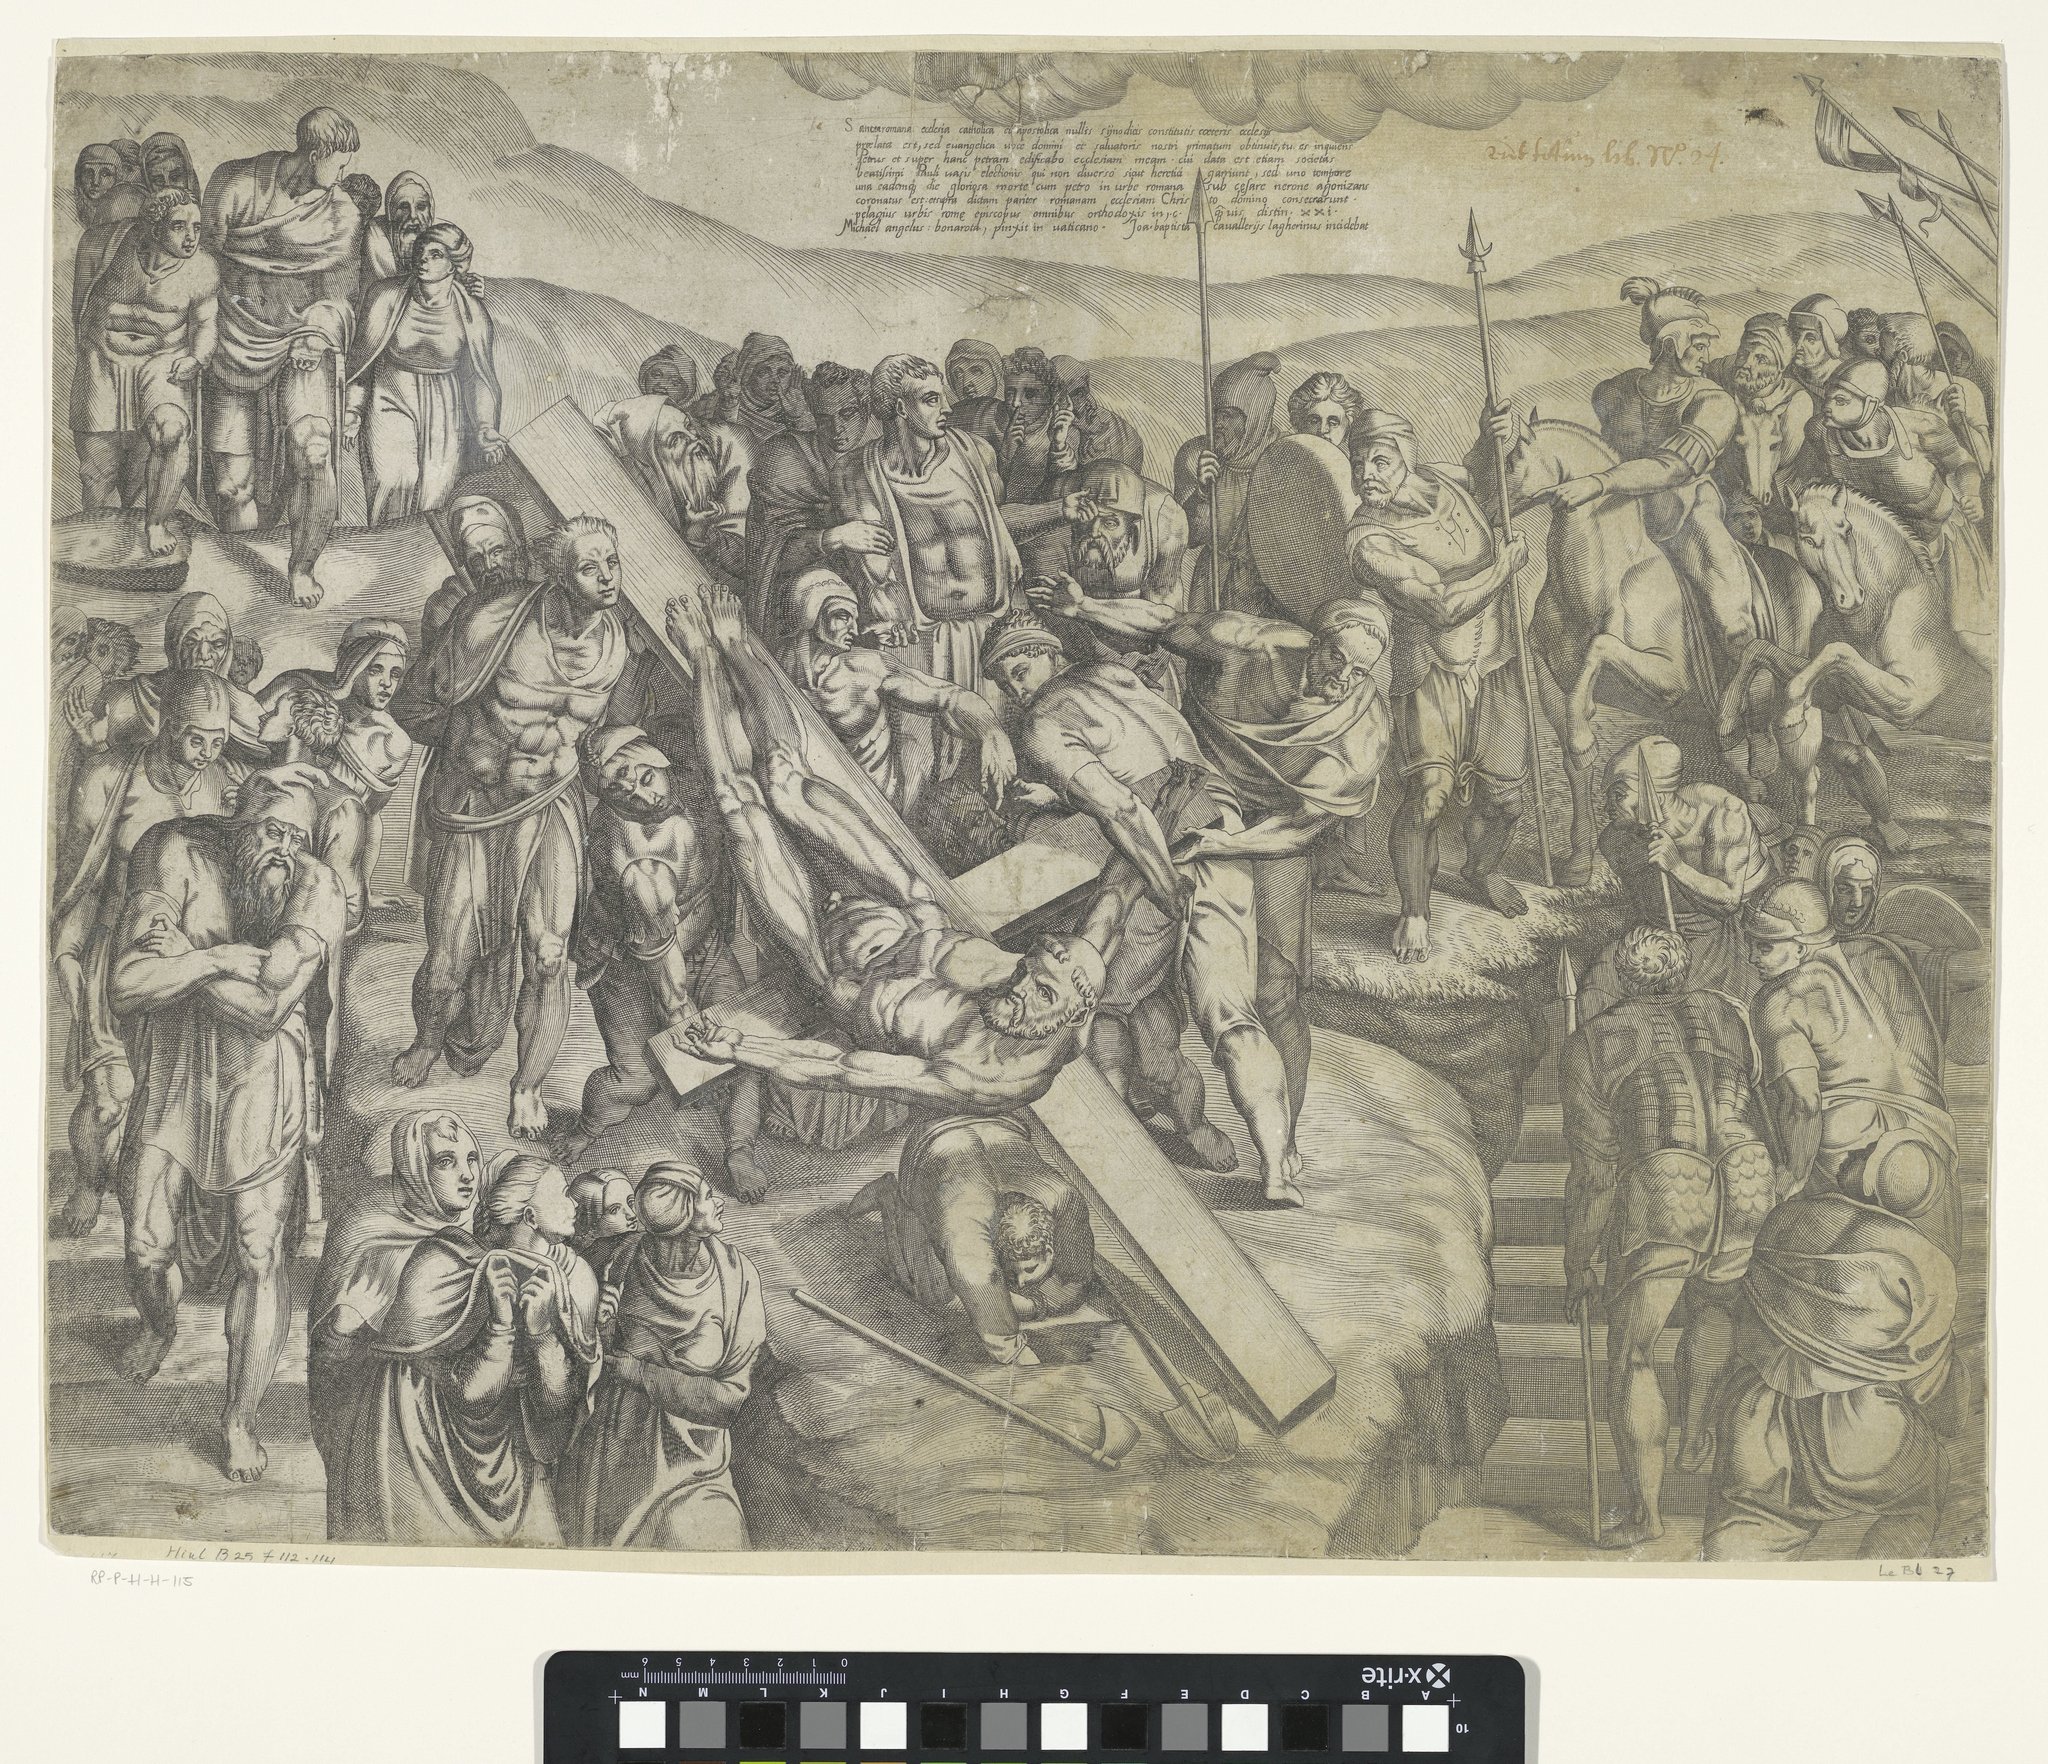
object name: print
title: Kruisiging van Petrus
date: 1535-1601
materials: paper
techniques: engraving, etching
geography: italy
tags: peter crucified upside down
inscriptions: inscription: ‘[...] lib. No. 24.’, collector's mark: Lugt 10, collector's mark: Lugt 11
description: Petrus hangt ondersteboven aan een kruis genageld. Een groep mannen is bezig het kruis op te richten. Een menigte kijkt toe.